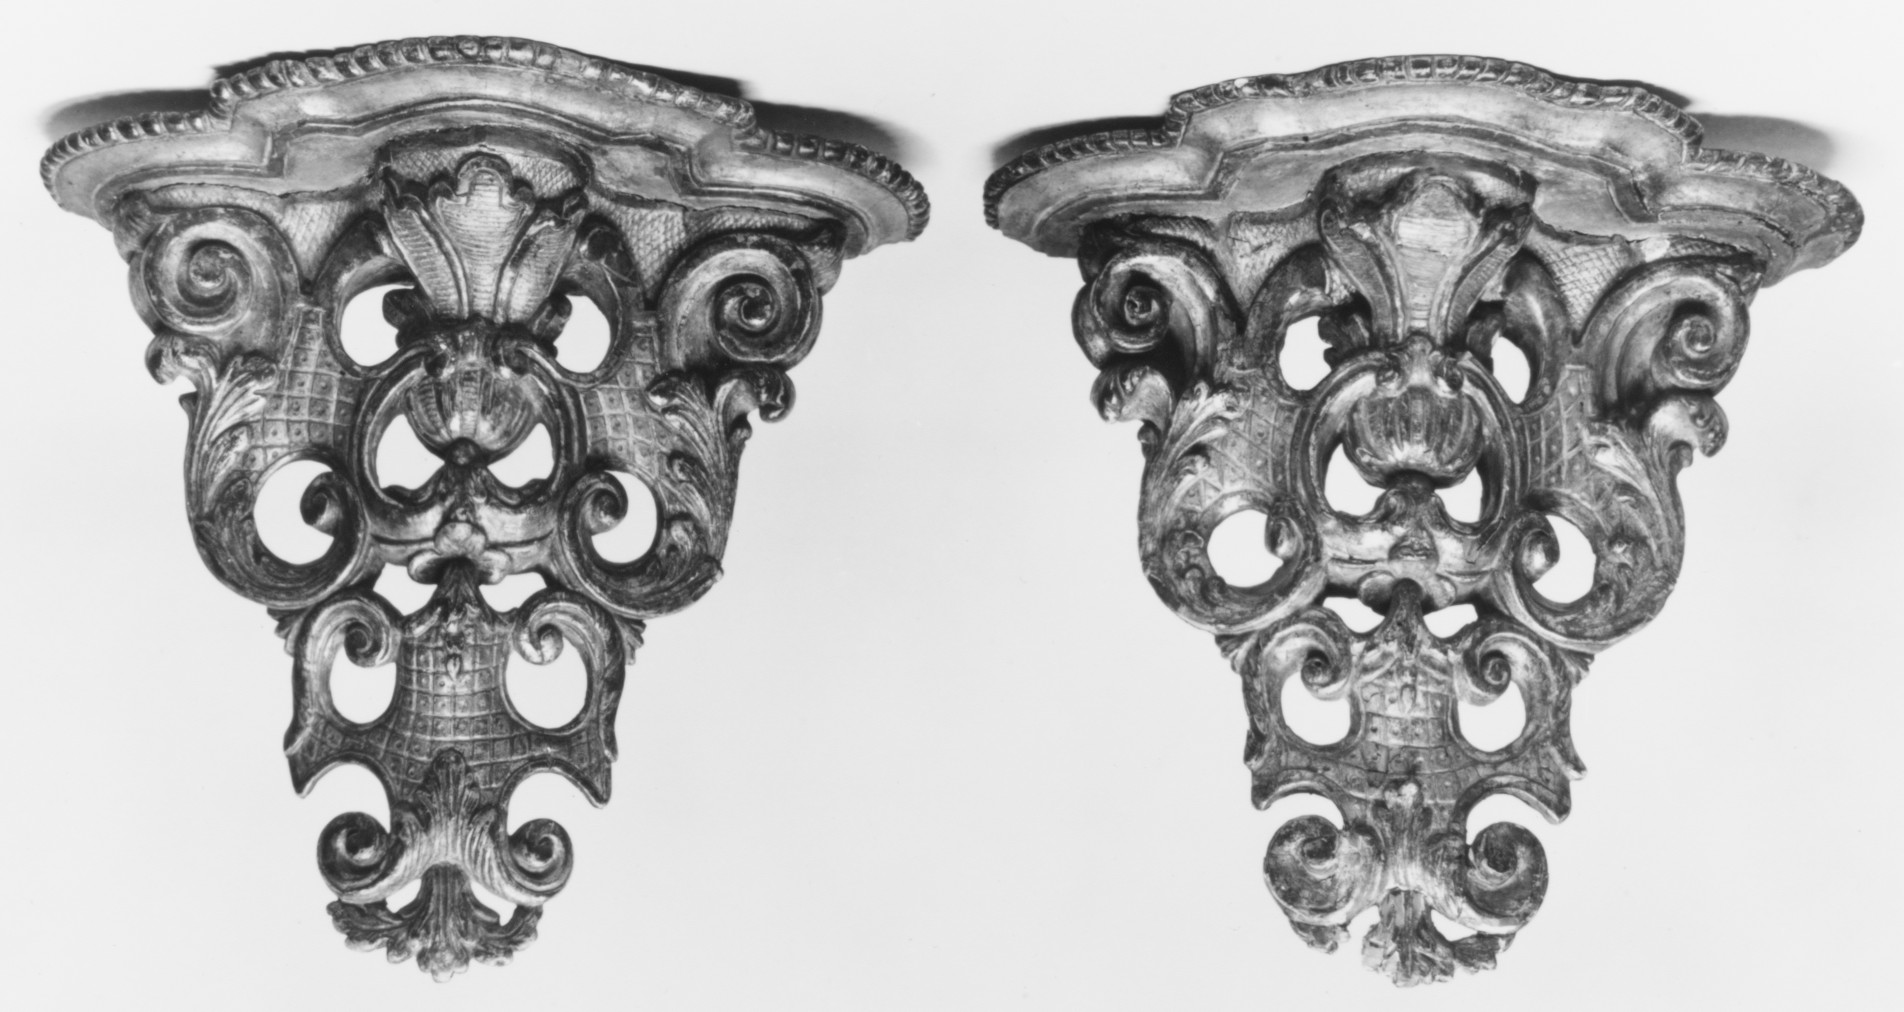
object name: wall bracket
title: Pair of wall brackets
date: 1720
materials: wood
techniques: carving, gilding